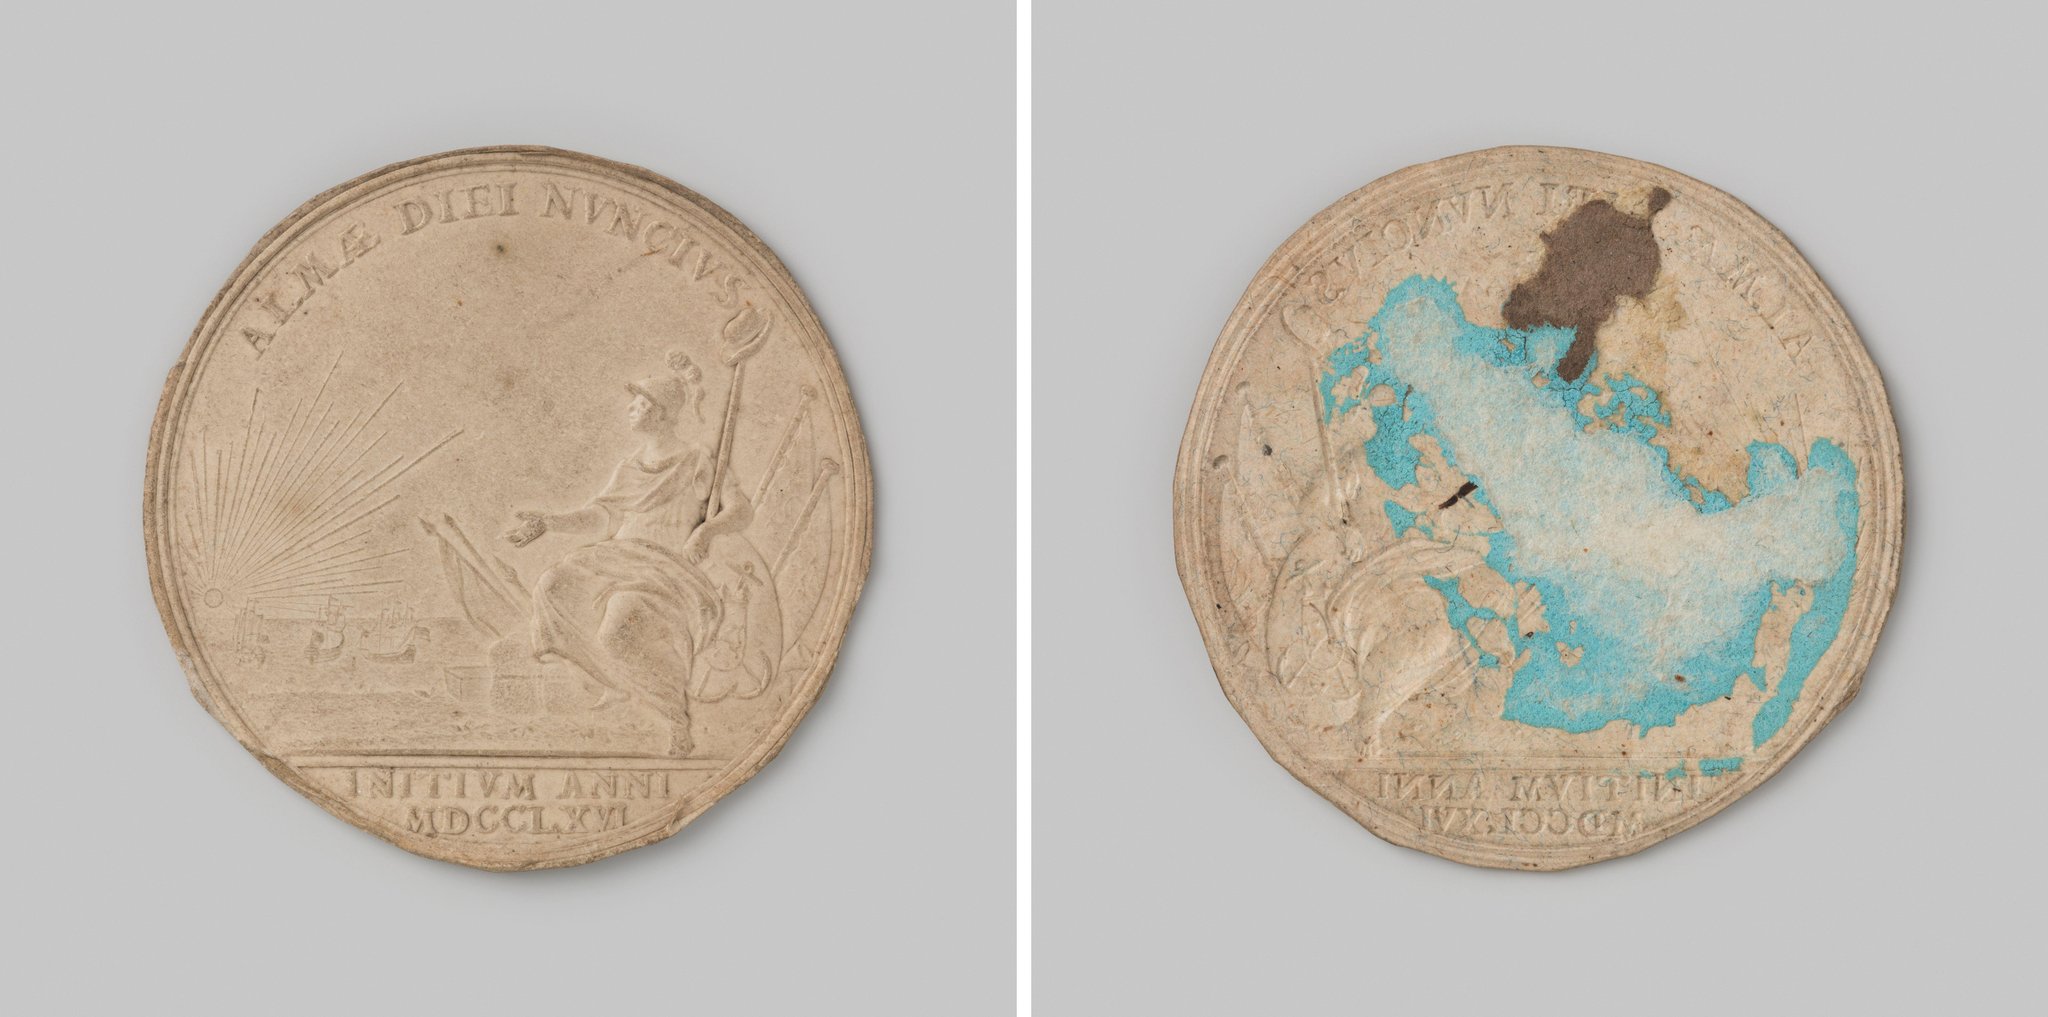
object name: history medal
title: Aanvang van het nieuwe jaar 1764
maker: johan george holtzhey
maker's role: mintmaster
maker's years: 1726-1808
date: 1763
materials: cardboard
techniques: pressing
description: Afdruk in karton van het keerzijdestempel van een penning, met de Nederlandse Koopvaardij als zittende gehelmde vrouw met piek met vrijheidshoed en een schild met gekruisde ankers en de Nederlandse leeuw, te midden van koopwaar en de vlaggen van VOC en GWC, waarachter koopvaardijschepen met een opgaande zon, met omschrift en afsnedetekst.